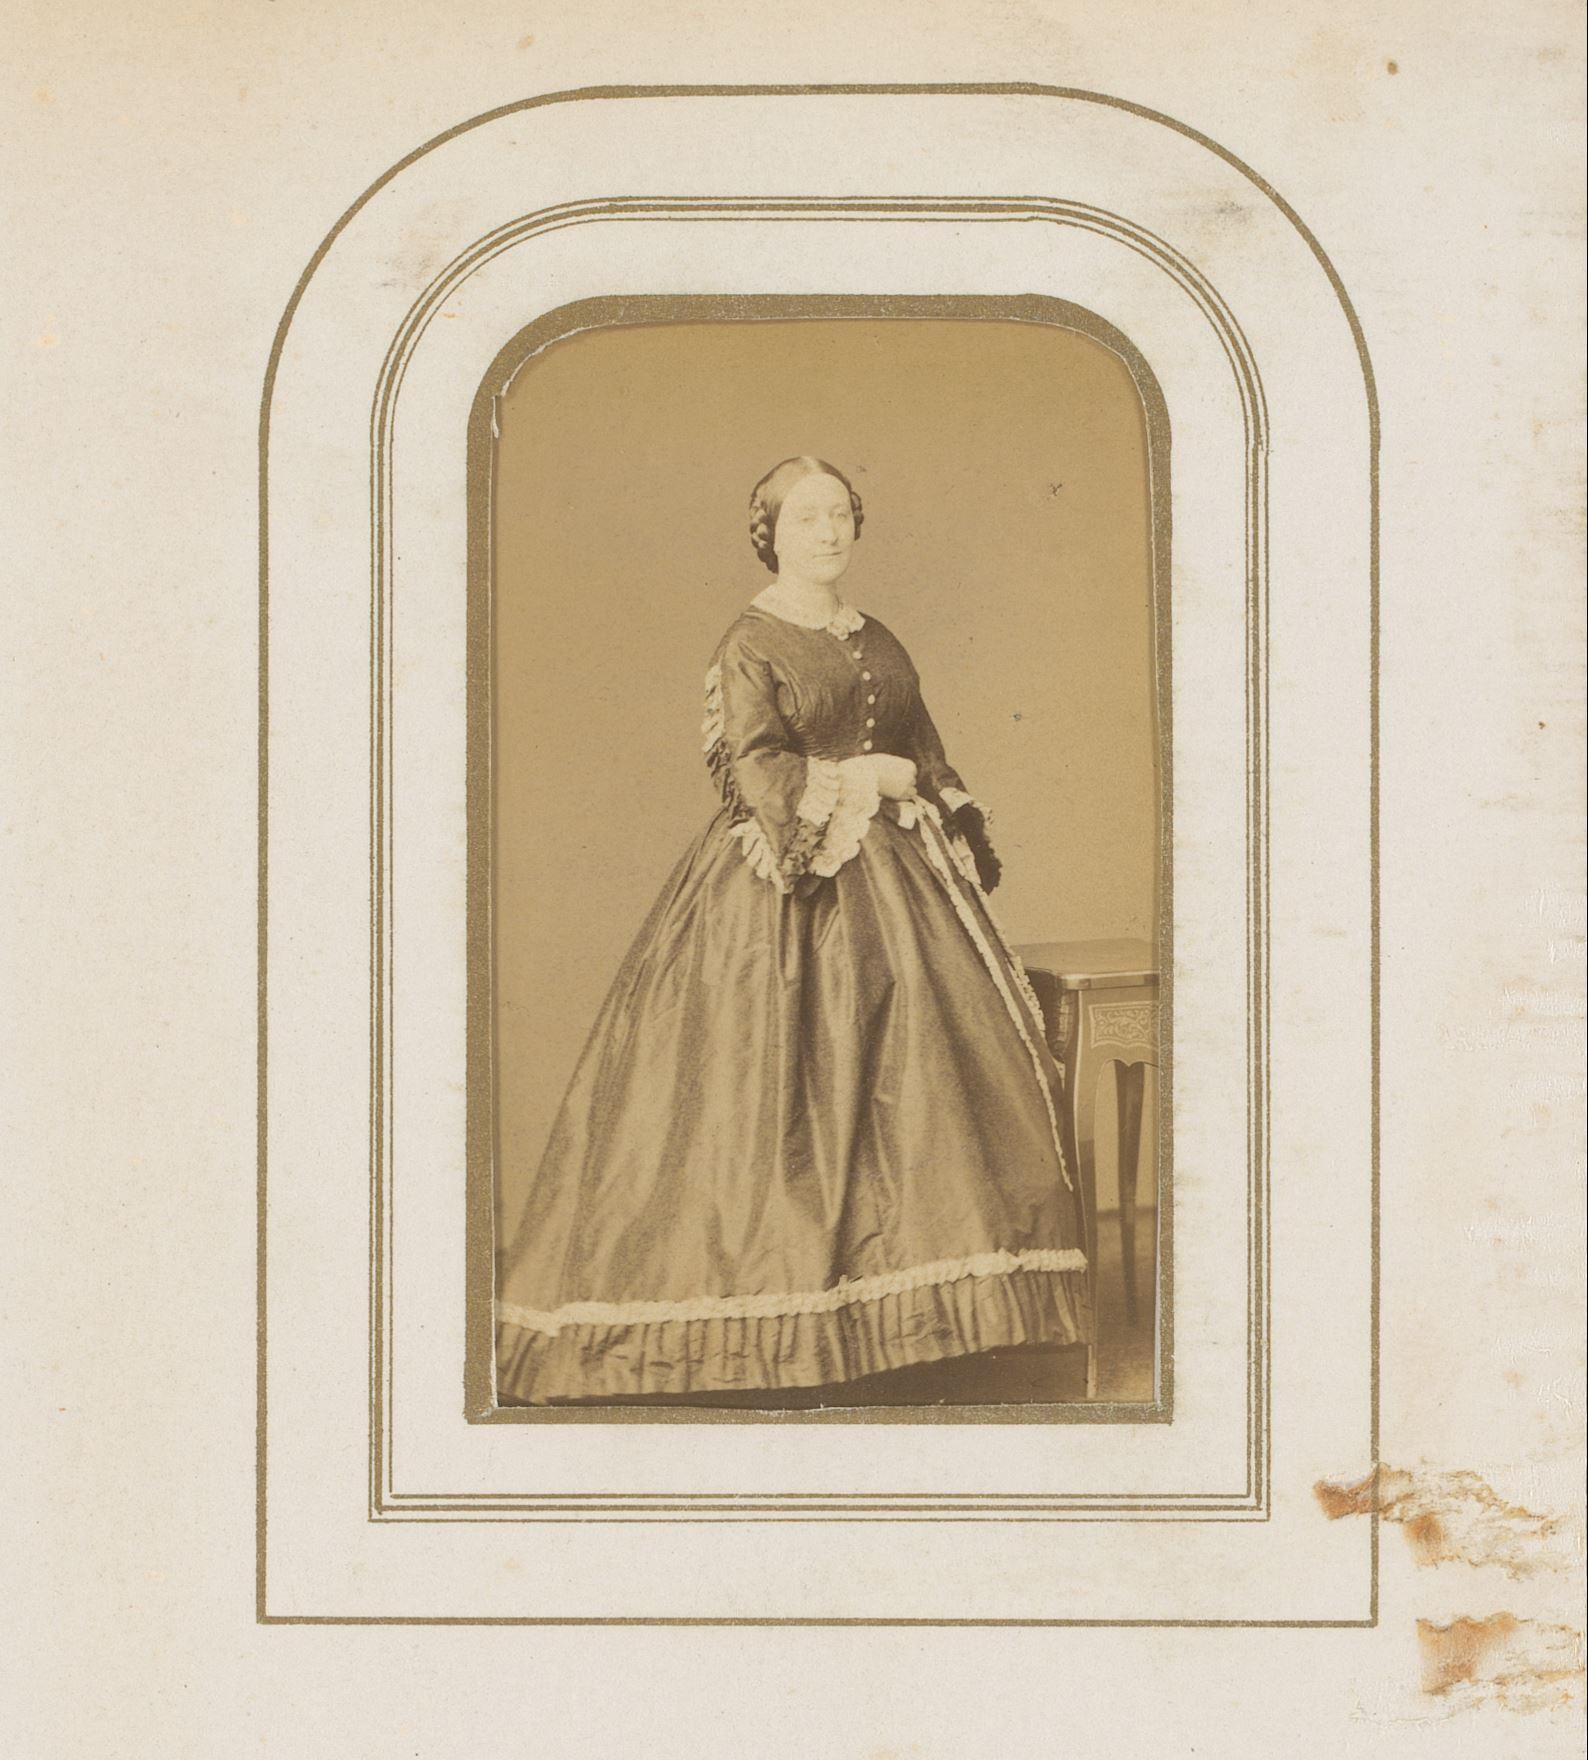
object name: photograph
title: Portret van een vrouw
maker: albert baron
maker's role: fotograaf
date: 1861-1865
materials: cardboard, photographic support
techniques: albumen print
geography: brussels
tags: historical persons - bb - woman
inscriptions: inscription: ‘Albert Baron/ Photographe/ Rue de l'ecuyer, 38/ en face le Théatre/ des Galeries/ Bruxelles’